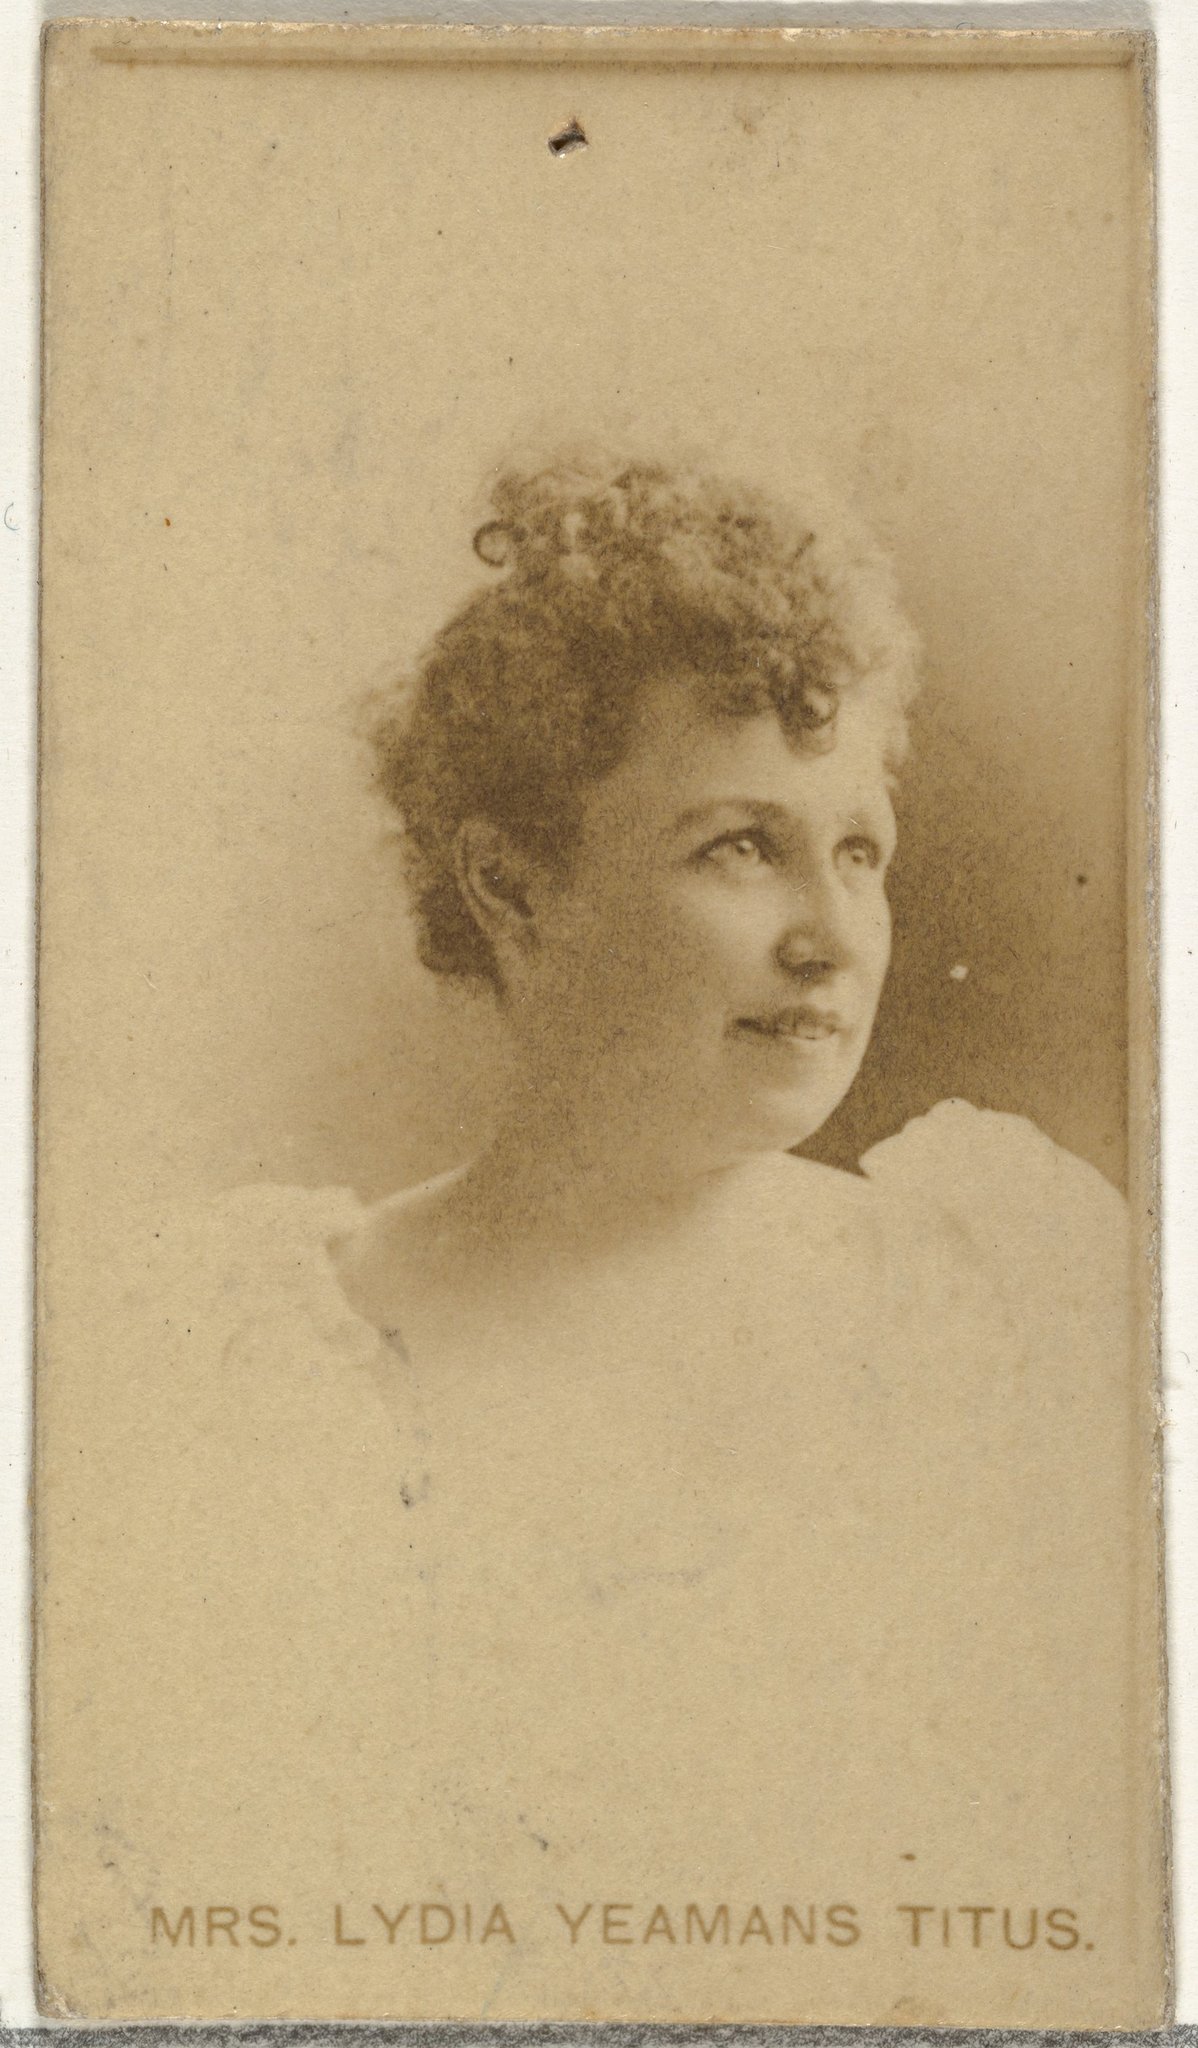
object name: photograph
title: Mrs. Lydia Yeamans Titus, from the Actors and Actresses series (N145-8) issued by Duke Sons & Co. to promote Duke Cigarettes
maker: w. duke, sons & co.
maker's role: publisher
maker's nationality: american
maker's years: 1870-1920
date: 1891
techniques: albumen silver print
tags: portraits,women,actresses